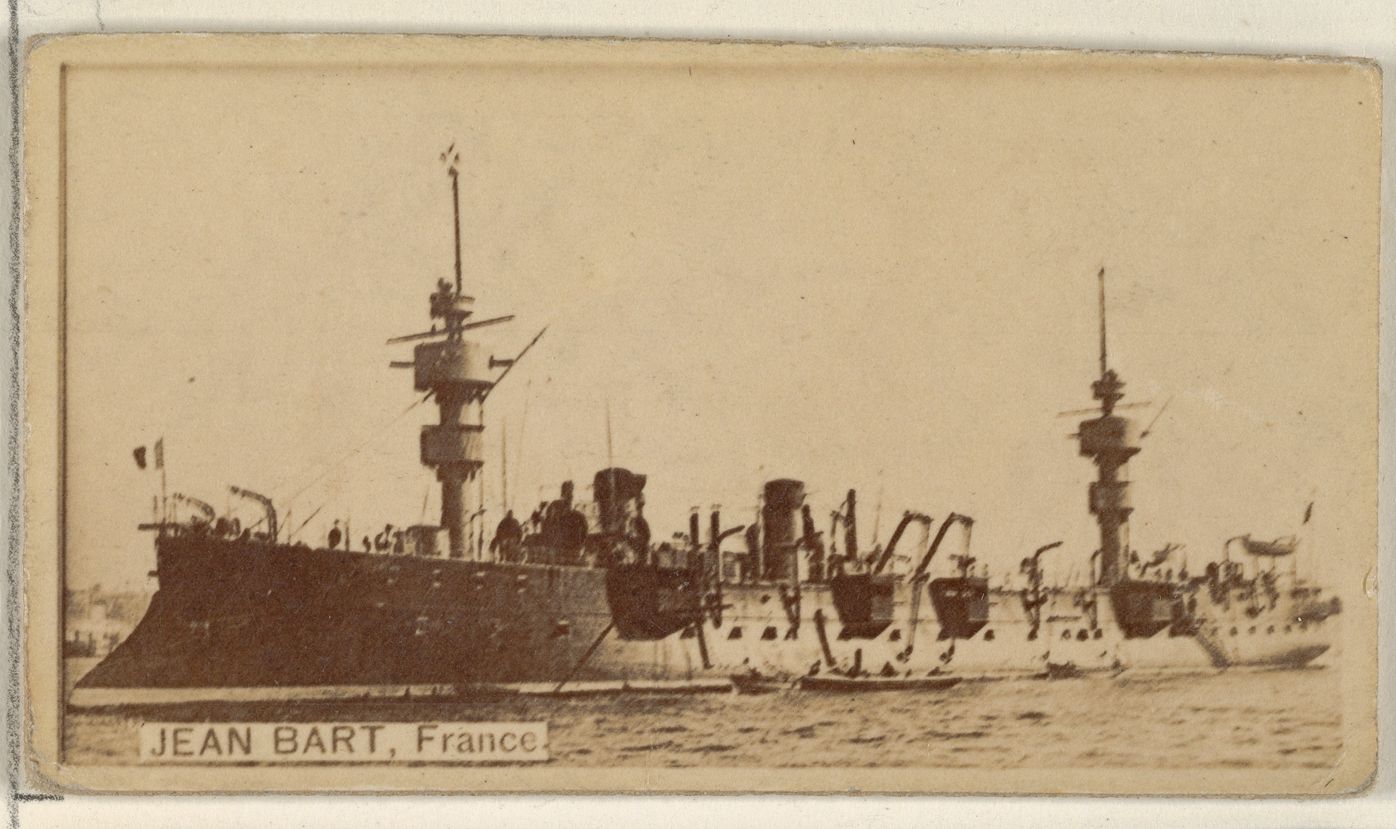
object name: photograph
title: Jean Bart, France, from the Famous Ships series (N50) for Virginia Brights Cigarettes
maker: allen & ginter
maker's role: publisher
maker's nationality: american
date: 1895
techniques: albumen silver print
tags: ships